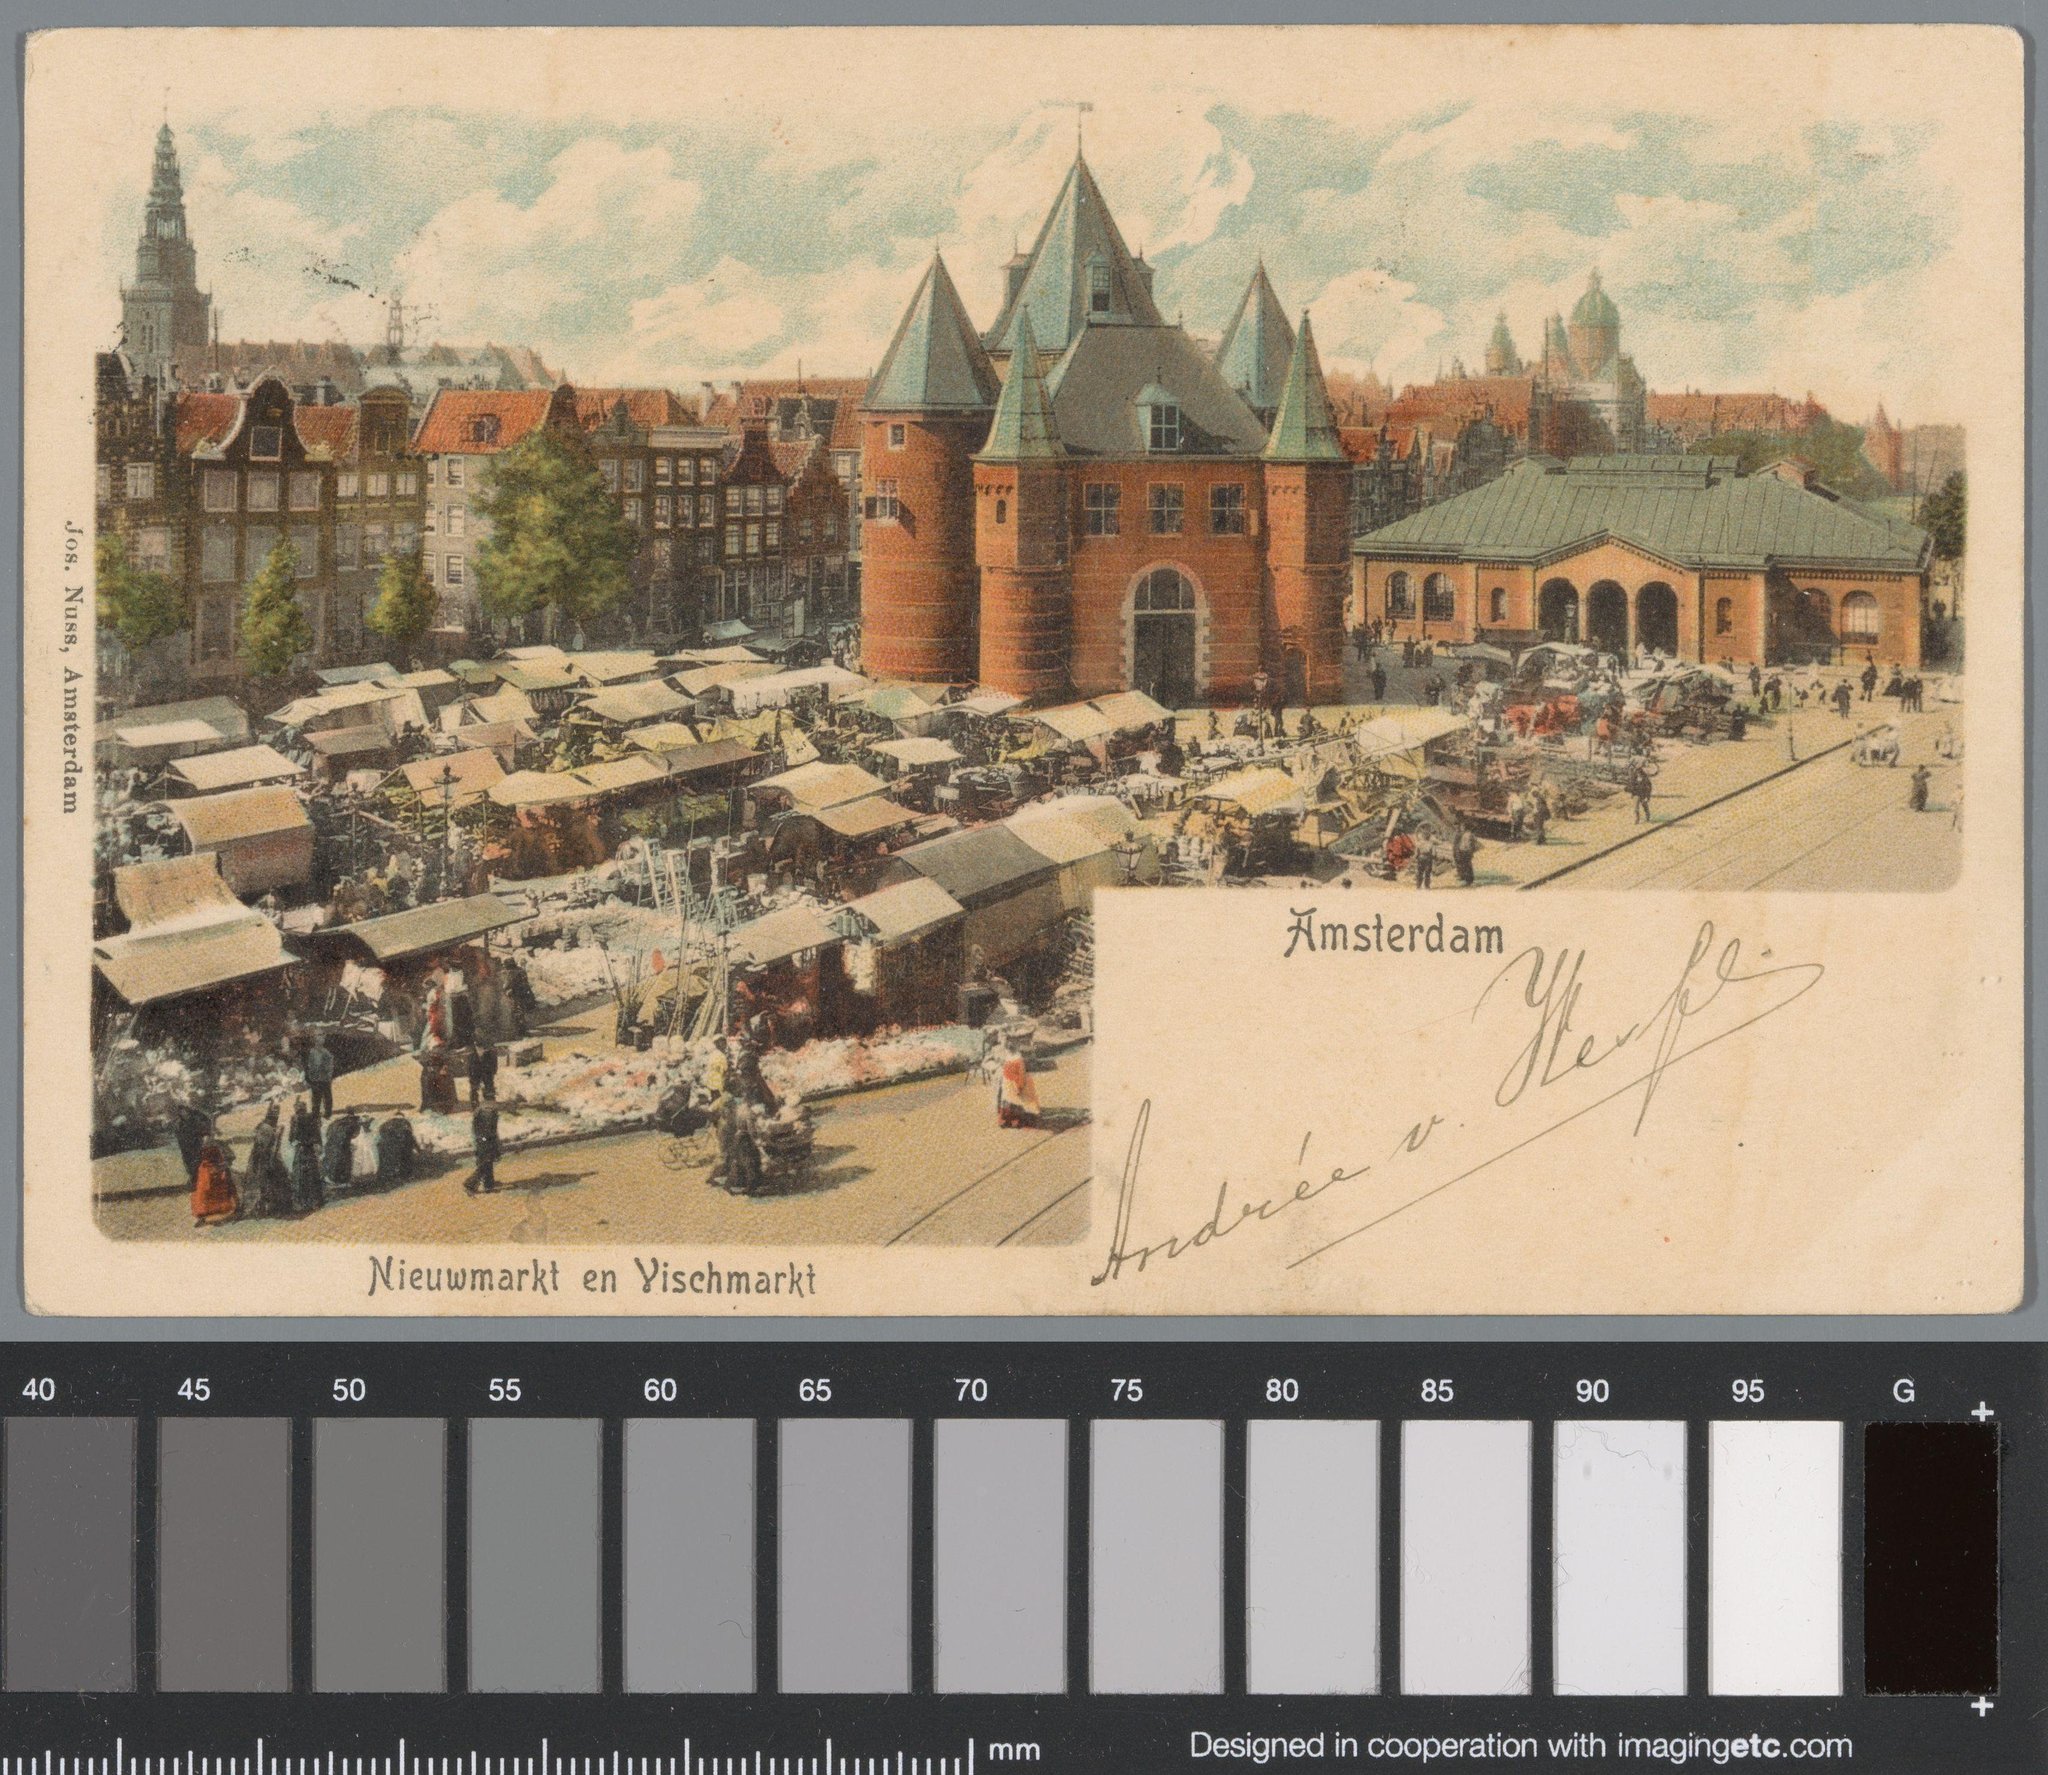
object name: ansichtkaart, prentbriefkaart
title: Nieuwmarkt en Vischmarkt, Amsterdam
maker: jos. m.h. nuss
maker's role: publisher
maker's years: 1879-1954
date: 1901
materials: cardboard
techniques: photograph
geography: amsterdam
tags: square, place, circus, etc., weigh-house